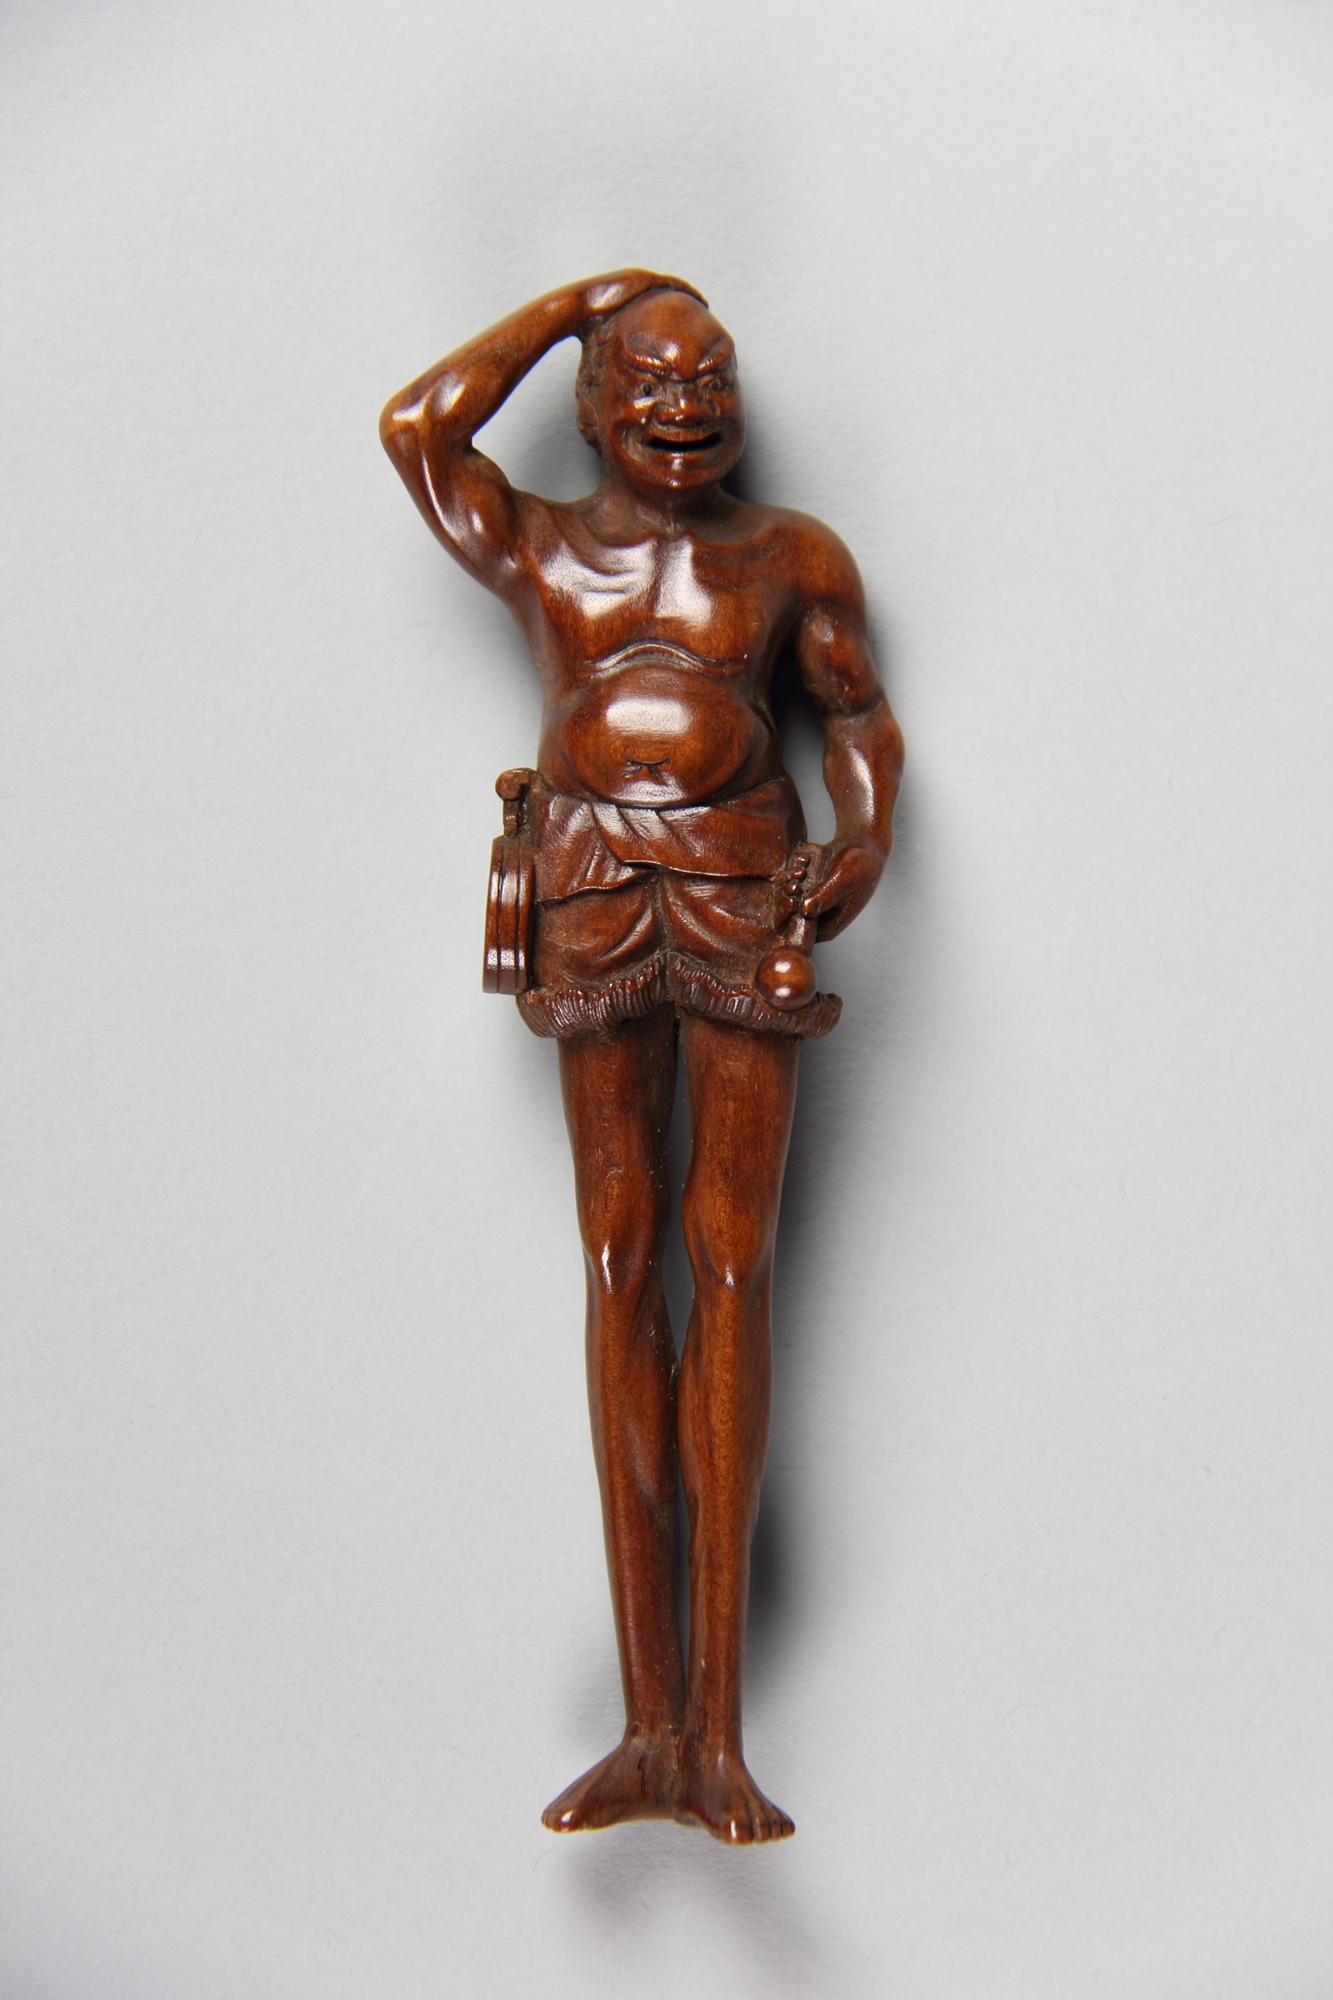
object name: netsuke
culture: japanese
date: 1801-1900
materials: wood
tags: men